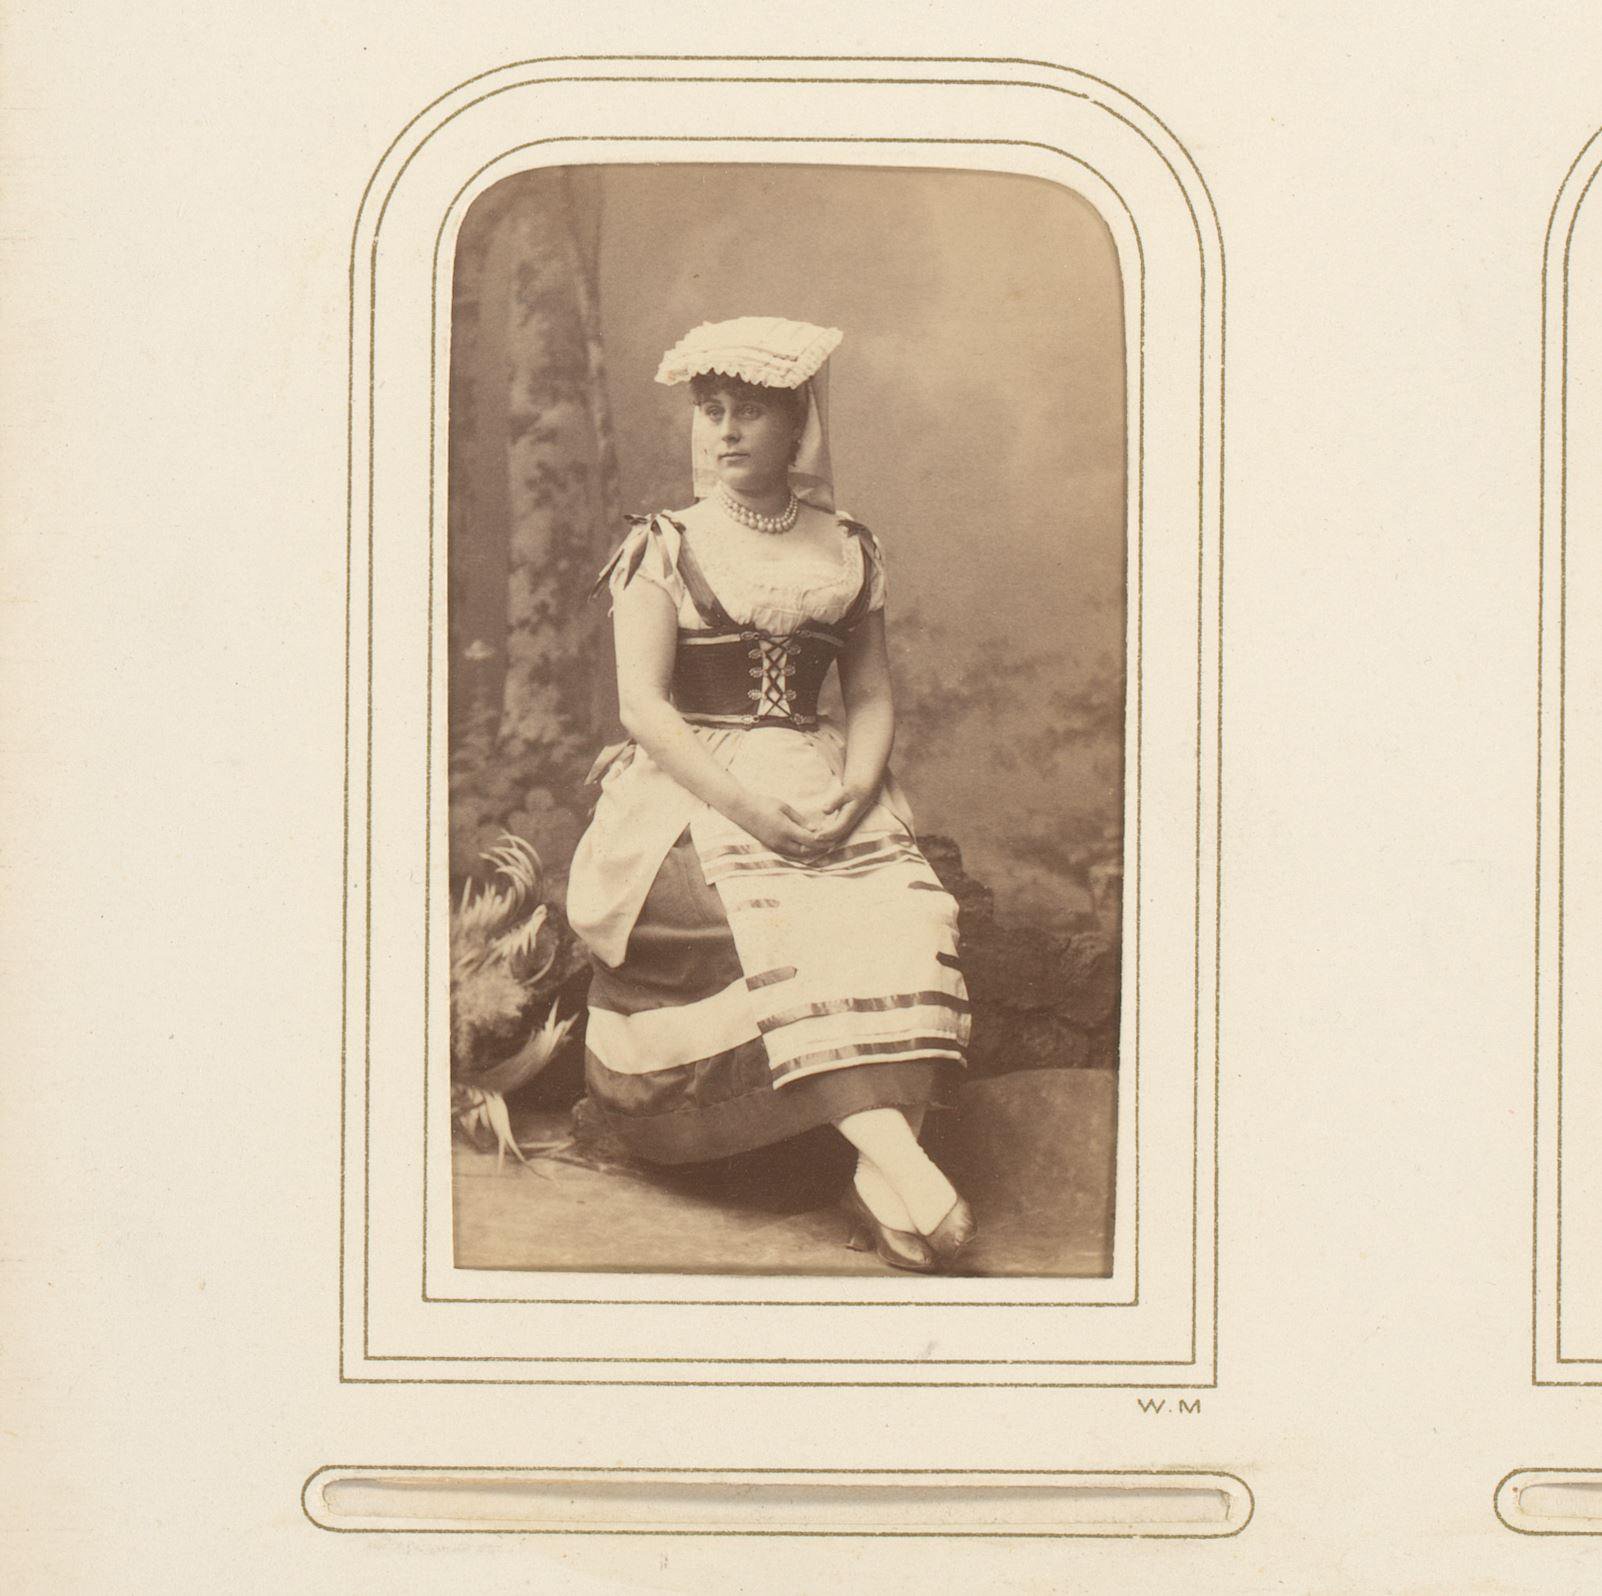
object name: photograph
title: Portret van Gerda Grönberg-Rove in kostuum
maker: gustaf alfred johanson dahllöf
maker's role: fotograaf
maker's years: 1841-1908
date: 1880-1890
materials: cardboard, photographic support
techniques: albumen print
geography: stockholm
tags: stage costume, historical persons - bb - woman, portrait of actor, actress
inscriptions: inscription: ‘Alfr. Json Dahllöf/ STOCKHOLM/ Klarabergsgatan 52A Klarabergsgatan/ Plåten förvaras för efterbeställning’, annotation: ‘Gerda Grönberg/ 1860 - 1936’